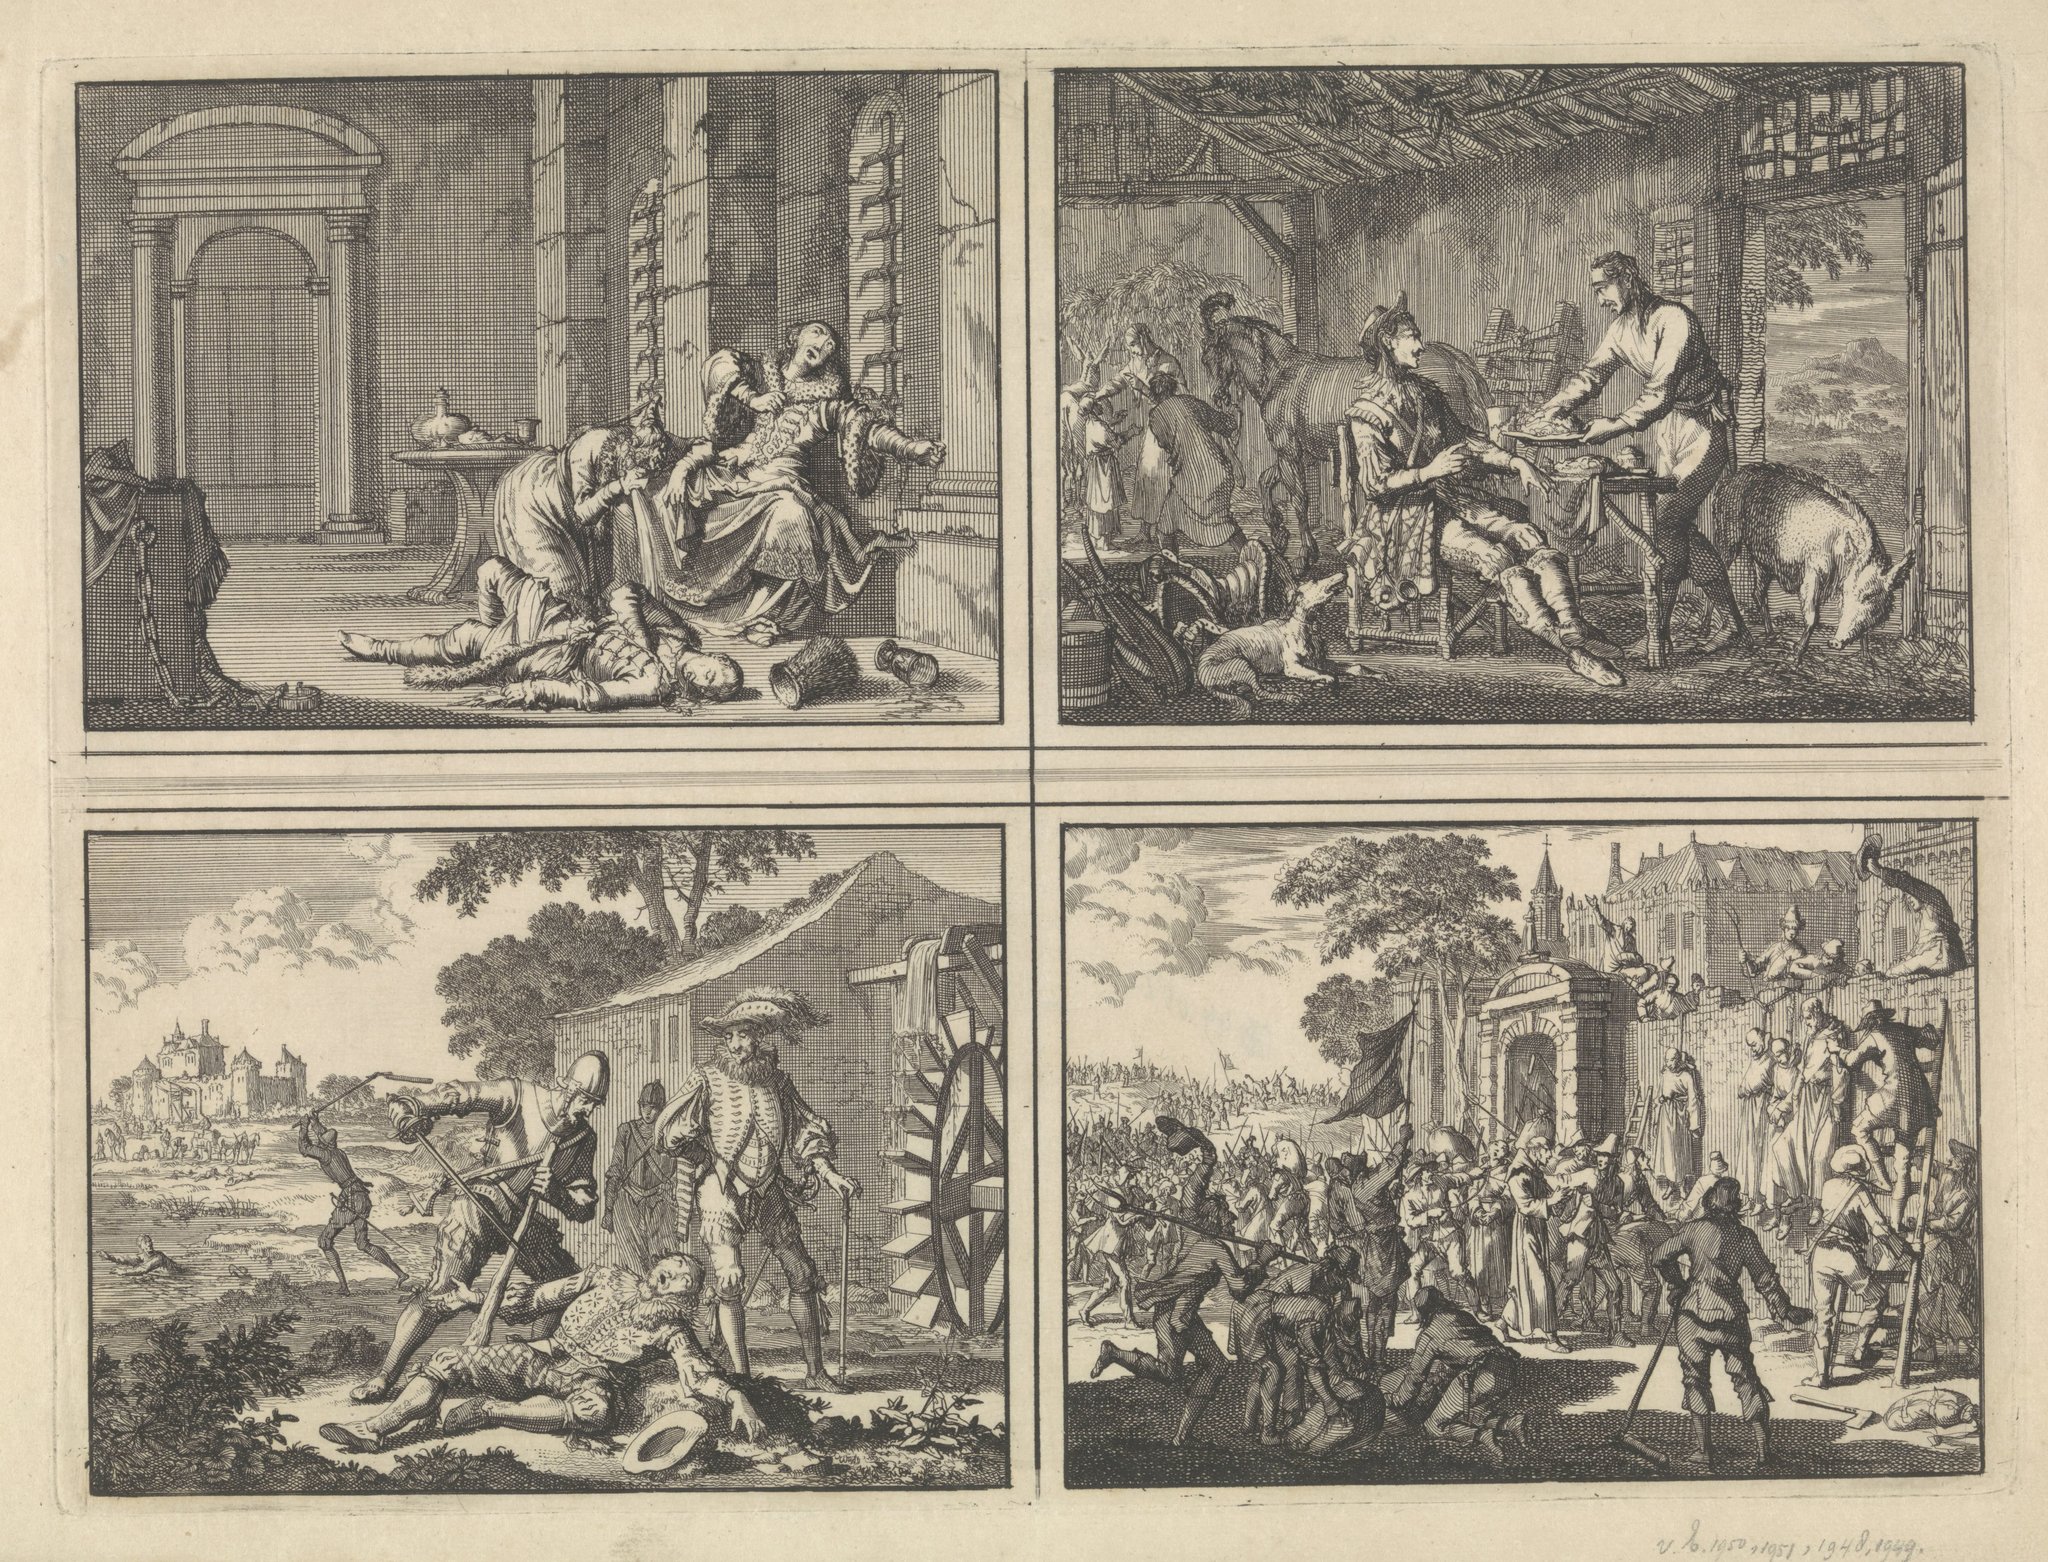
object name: print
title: Tsaar Fedor Borissowitz sterft vergiftigd in de gevangenis, 1605 / Philips II, koning van Spanje wordt opgenomen in de hut van een arme boer, ca. 1560 / Wirich von Daun, graaf van Falkenstein, bij een watermolen door Spanjaarden vermoord, 1598 / Monniken uit een klooster nabij Linz worden in de Boerenoorlog aan de muren van hun klooster opgehangen, 1596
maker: jan luyken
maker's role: draughtsman, print maker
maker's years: 1649-1712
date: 1698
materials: paper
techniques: etching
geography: amsterdam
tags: philip ii of spain, prison, jail, violent death by hanging, monk(s), friar(s), murder, cloisters ~ monastery, violent death by poison, watermill in landscape, farm (building) - aa - civic architecture: inside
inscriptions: collector's mark: Lugt 2228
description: Prenten gebruikt als illustratie in: Gottfried, Johann Ludwig. Historische kronyck; vervattende een (...) beschrijvingh der aldergedenckwaerdigste geschiedenissen des weerelds, van den aenvangh der scheppingh tot (...) 1576 (2 delen). Leiden: Pieter van der Aa, 1698, dl. I, p. 149, 165, 79, 93